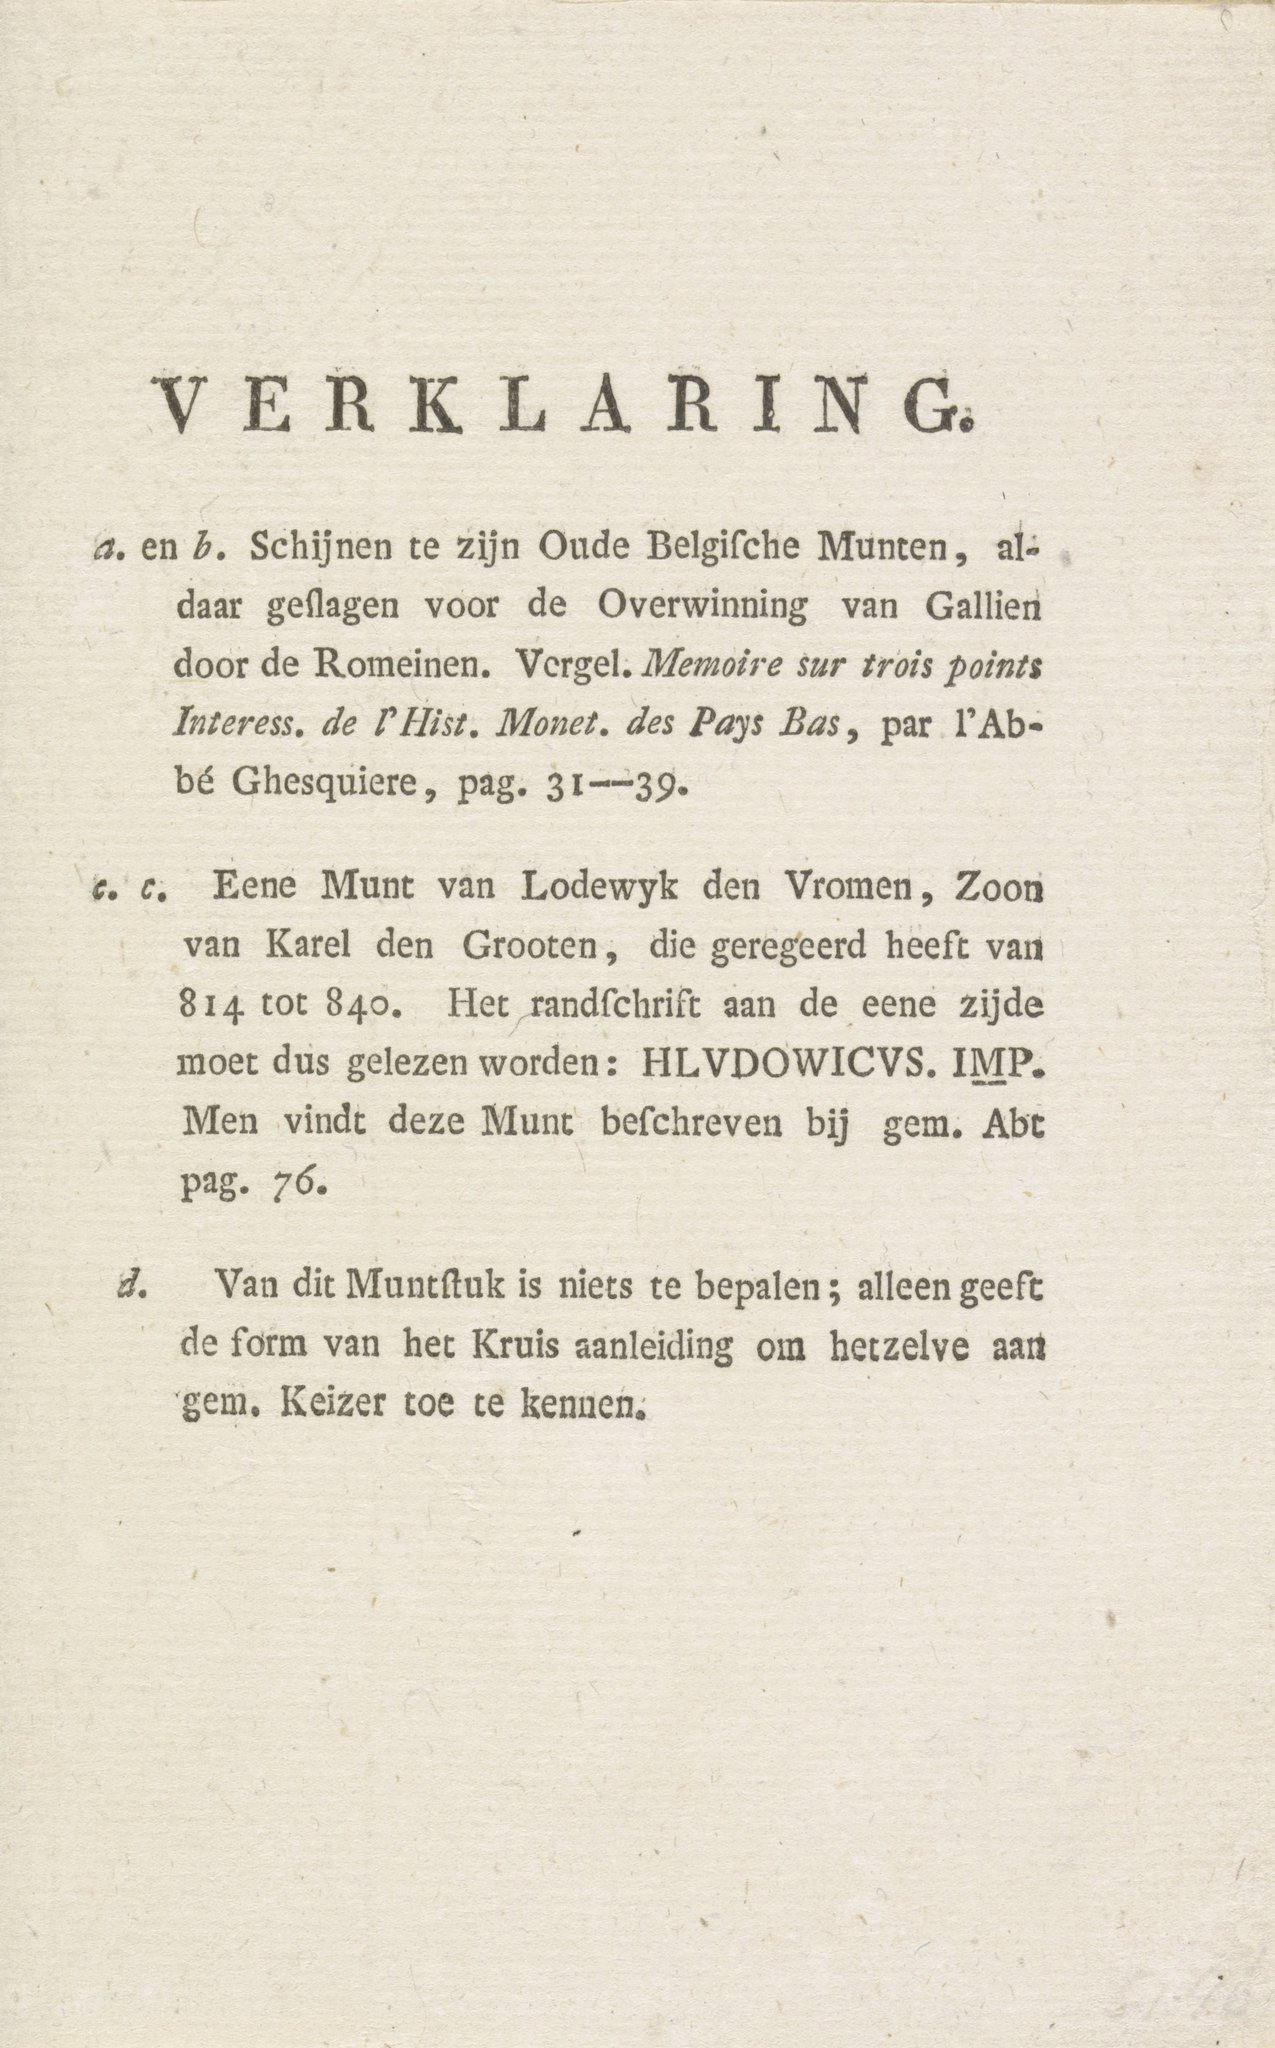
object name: text sheet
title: Verklaring bij de prent met de zilveren munten gevonden op het strand bij Domburg, 1817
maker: Anonymous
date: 1817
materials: paper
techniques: engraving, etching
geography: netherlands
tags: coin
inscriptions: collector's mark: Lugt Lugt 2228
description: Tekstblad met een beschrijving van de vier zilveren munten gevonden op het strand ten oosten van Domburg, augustus 1817. Dubbelgevouwen blad bedrukt op één zijde.